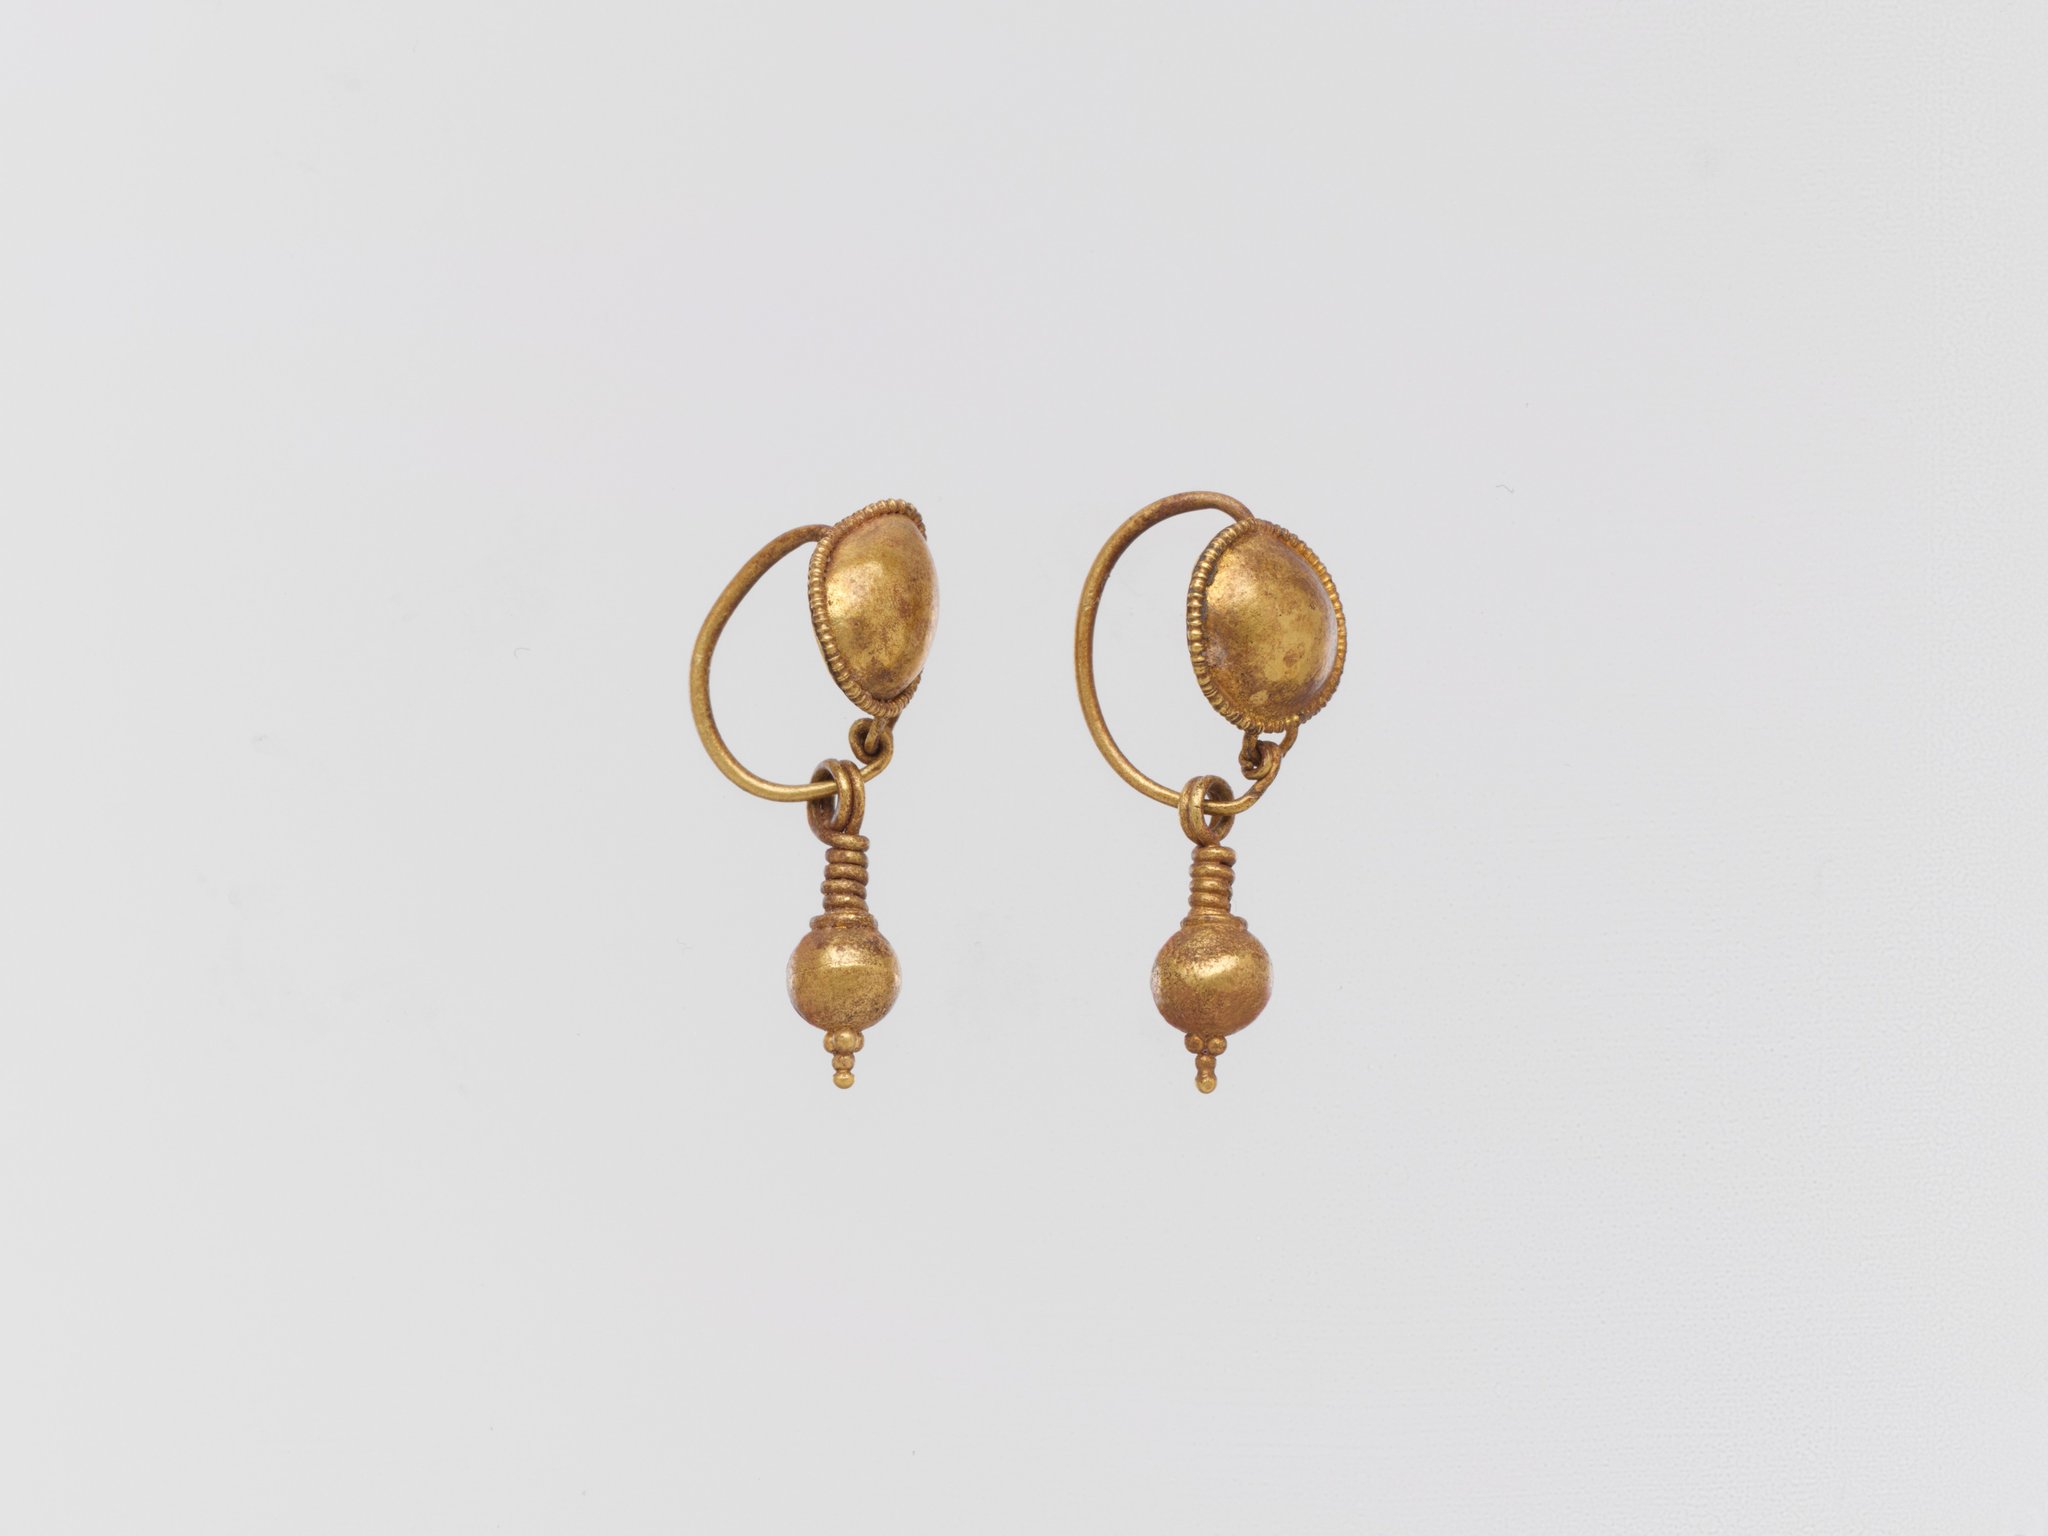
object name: earring with pendant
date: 7000 BCE-330 CE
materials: gold